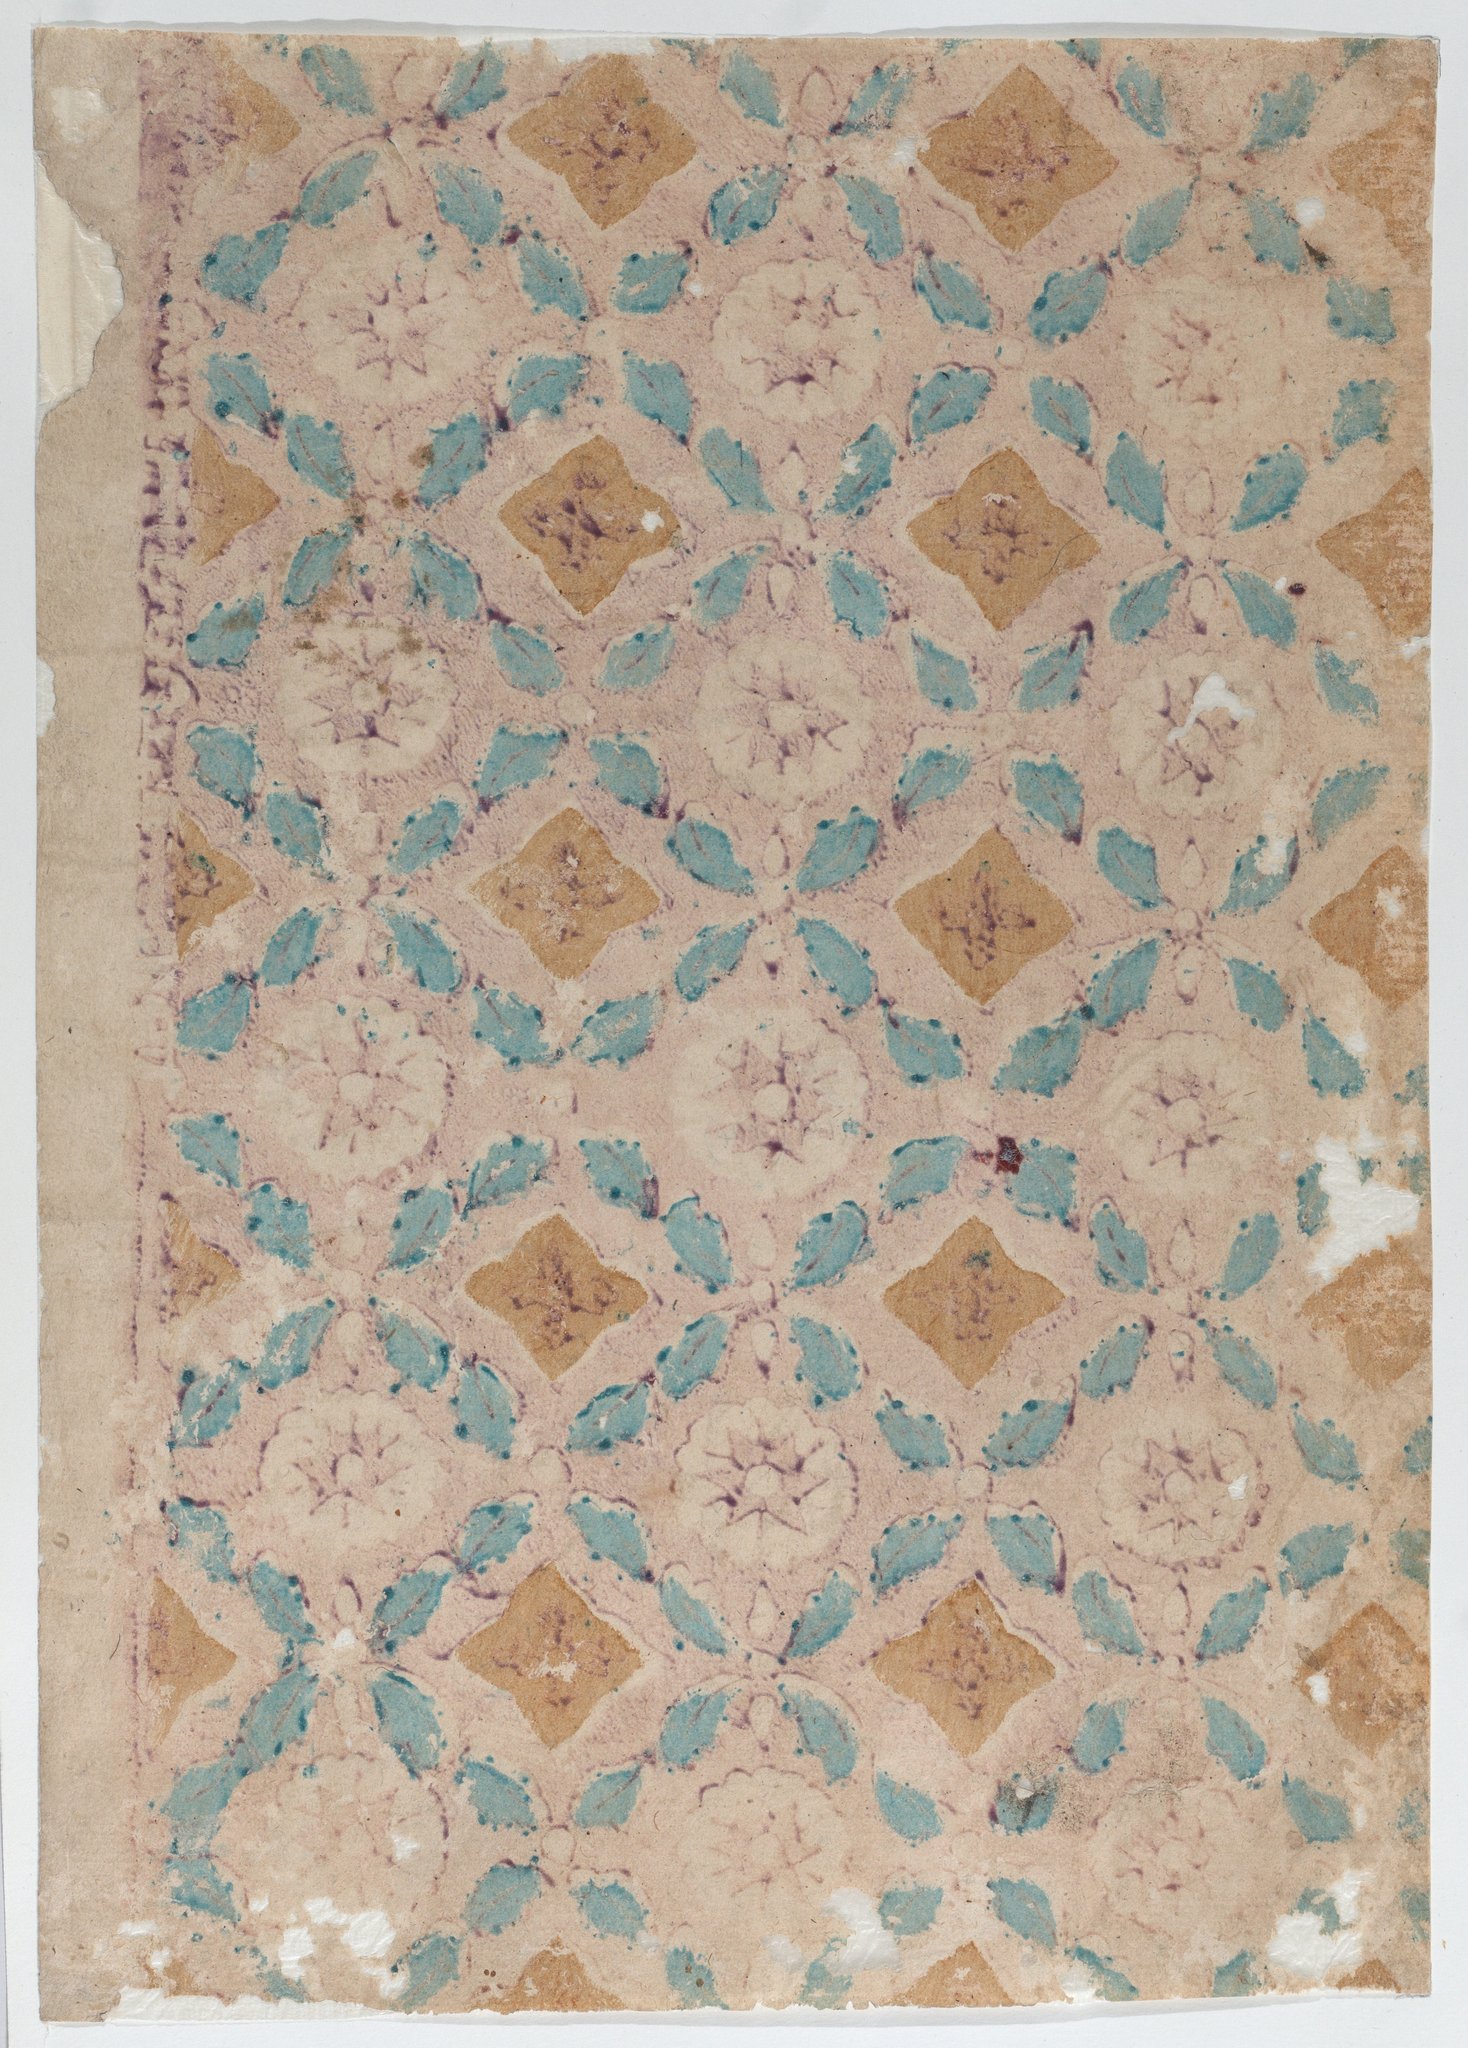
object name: print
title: Two sheets with geometric patterns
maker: Anonymous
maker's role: artist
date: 1701-1800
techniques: relief print